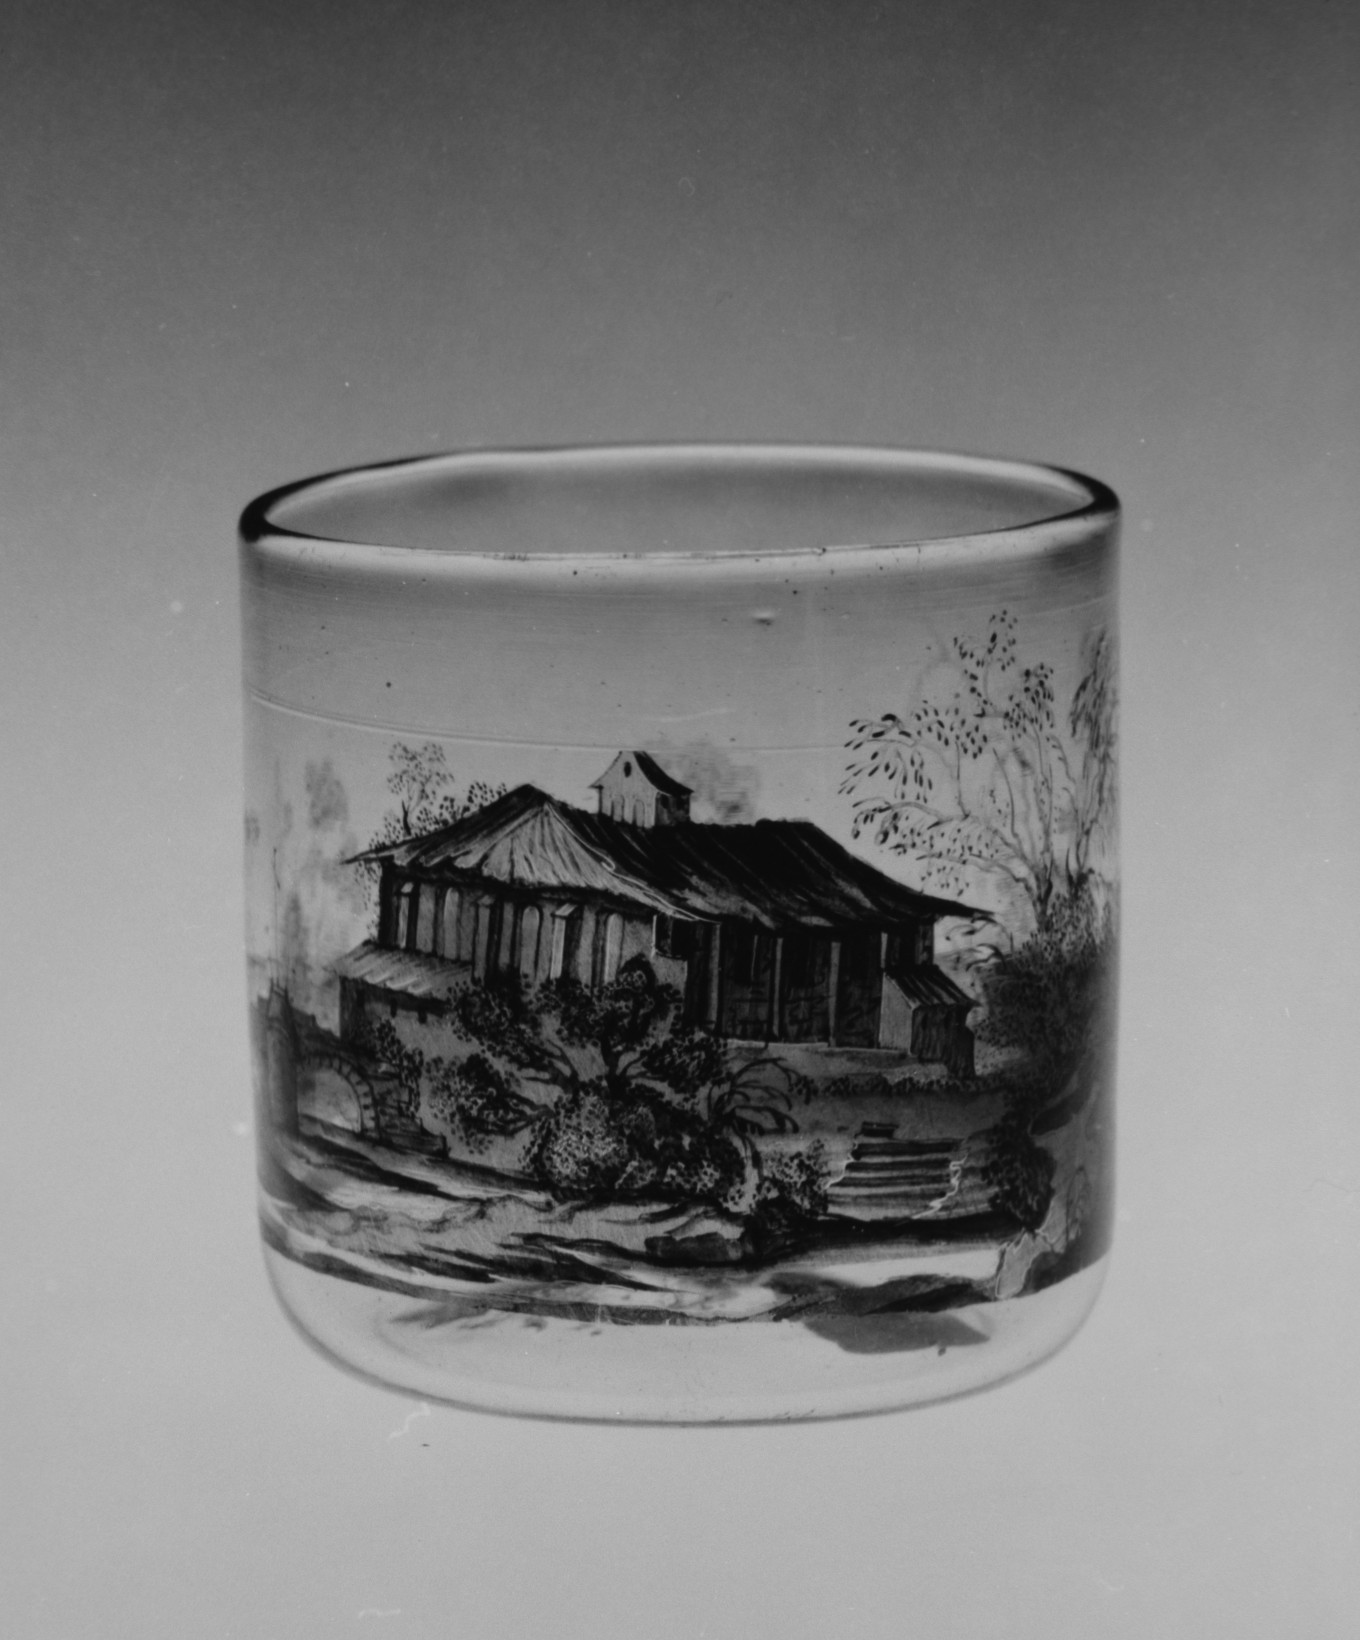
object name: beaker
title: Beaker (Schwarzlot cup)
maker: johann schaper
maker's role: decorator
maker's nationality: german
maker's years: 1621-1670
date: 1655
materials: glass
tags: houses